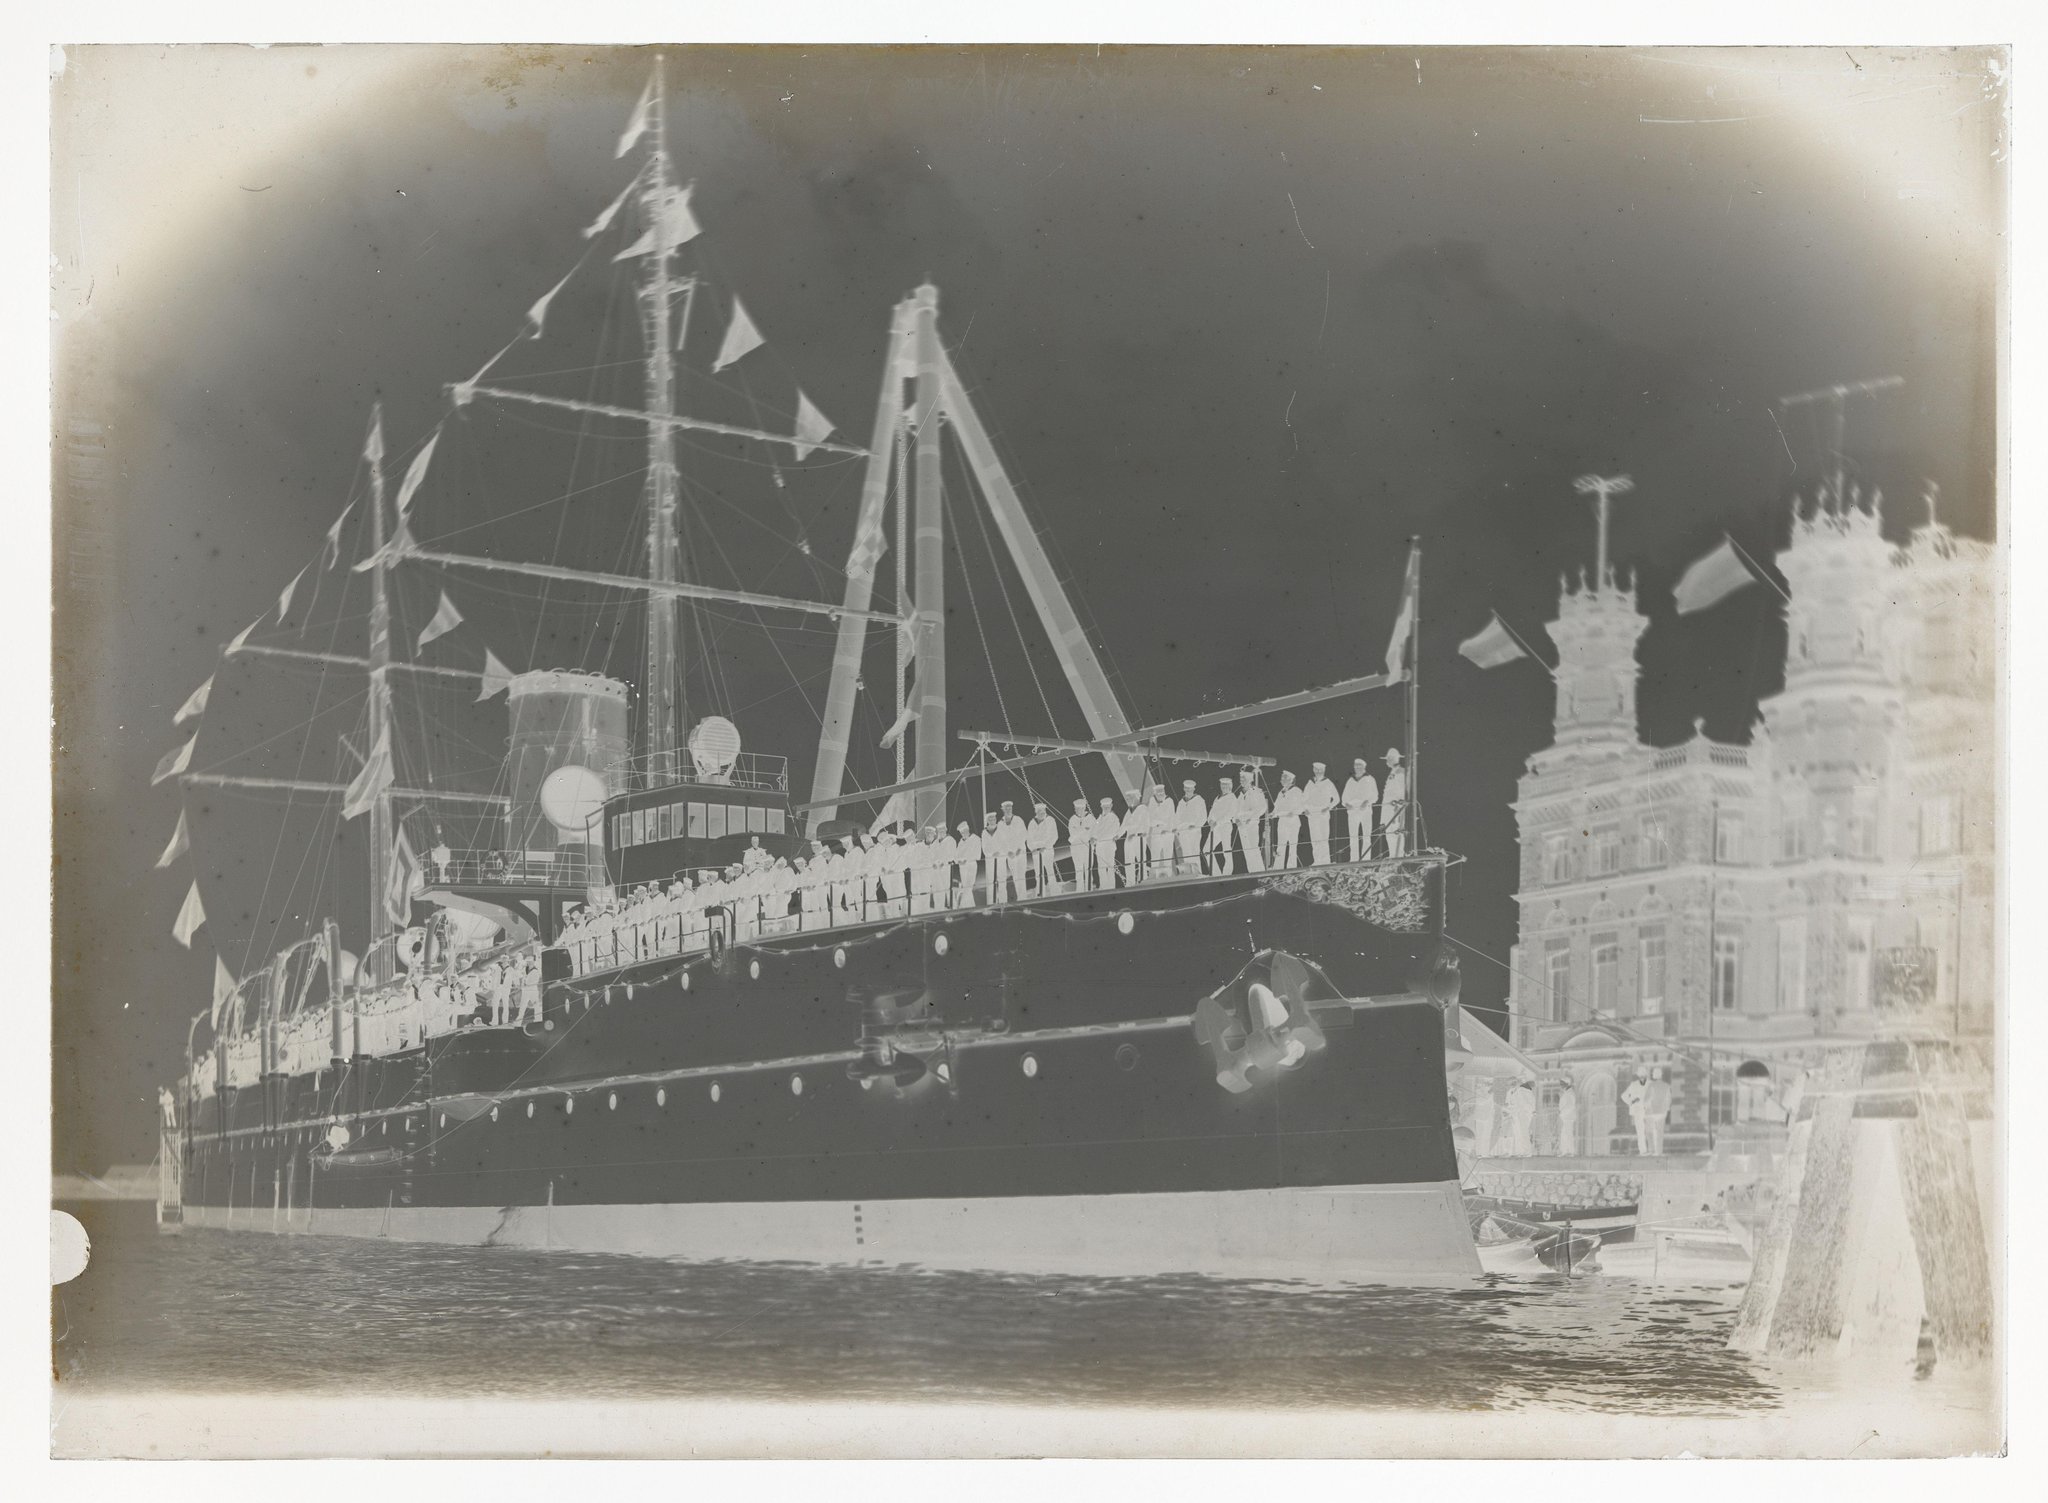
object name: glasnegatief, glasplaatnegatief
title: Schip met bemanning in een haven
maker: machiel gerrit george suyver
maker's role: fotograaf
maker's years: 1872-1933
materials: glass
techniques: gelatin glass negative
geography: netherlands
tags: harbour, steamship, motorship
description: Hr. Ms. kruiser Utrecht aan de Oostelijke Handelskade in Amsterdam.